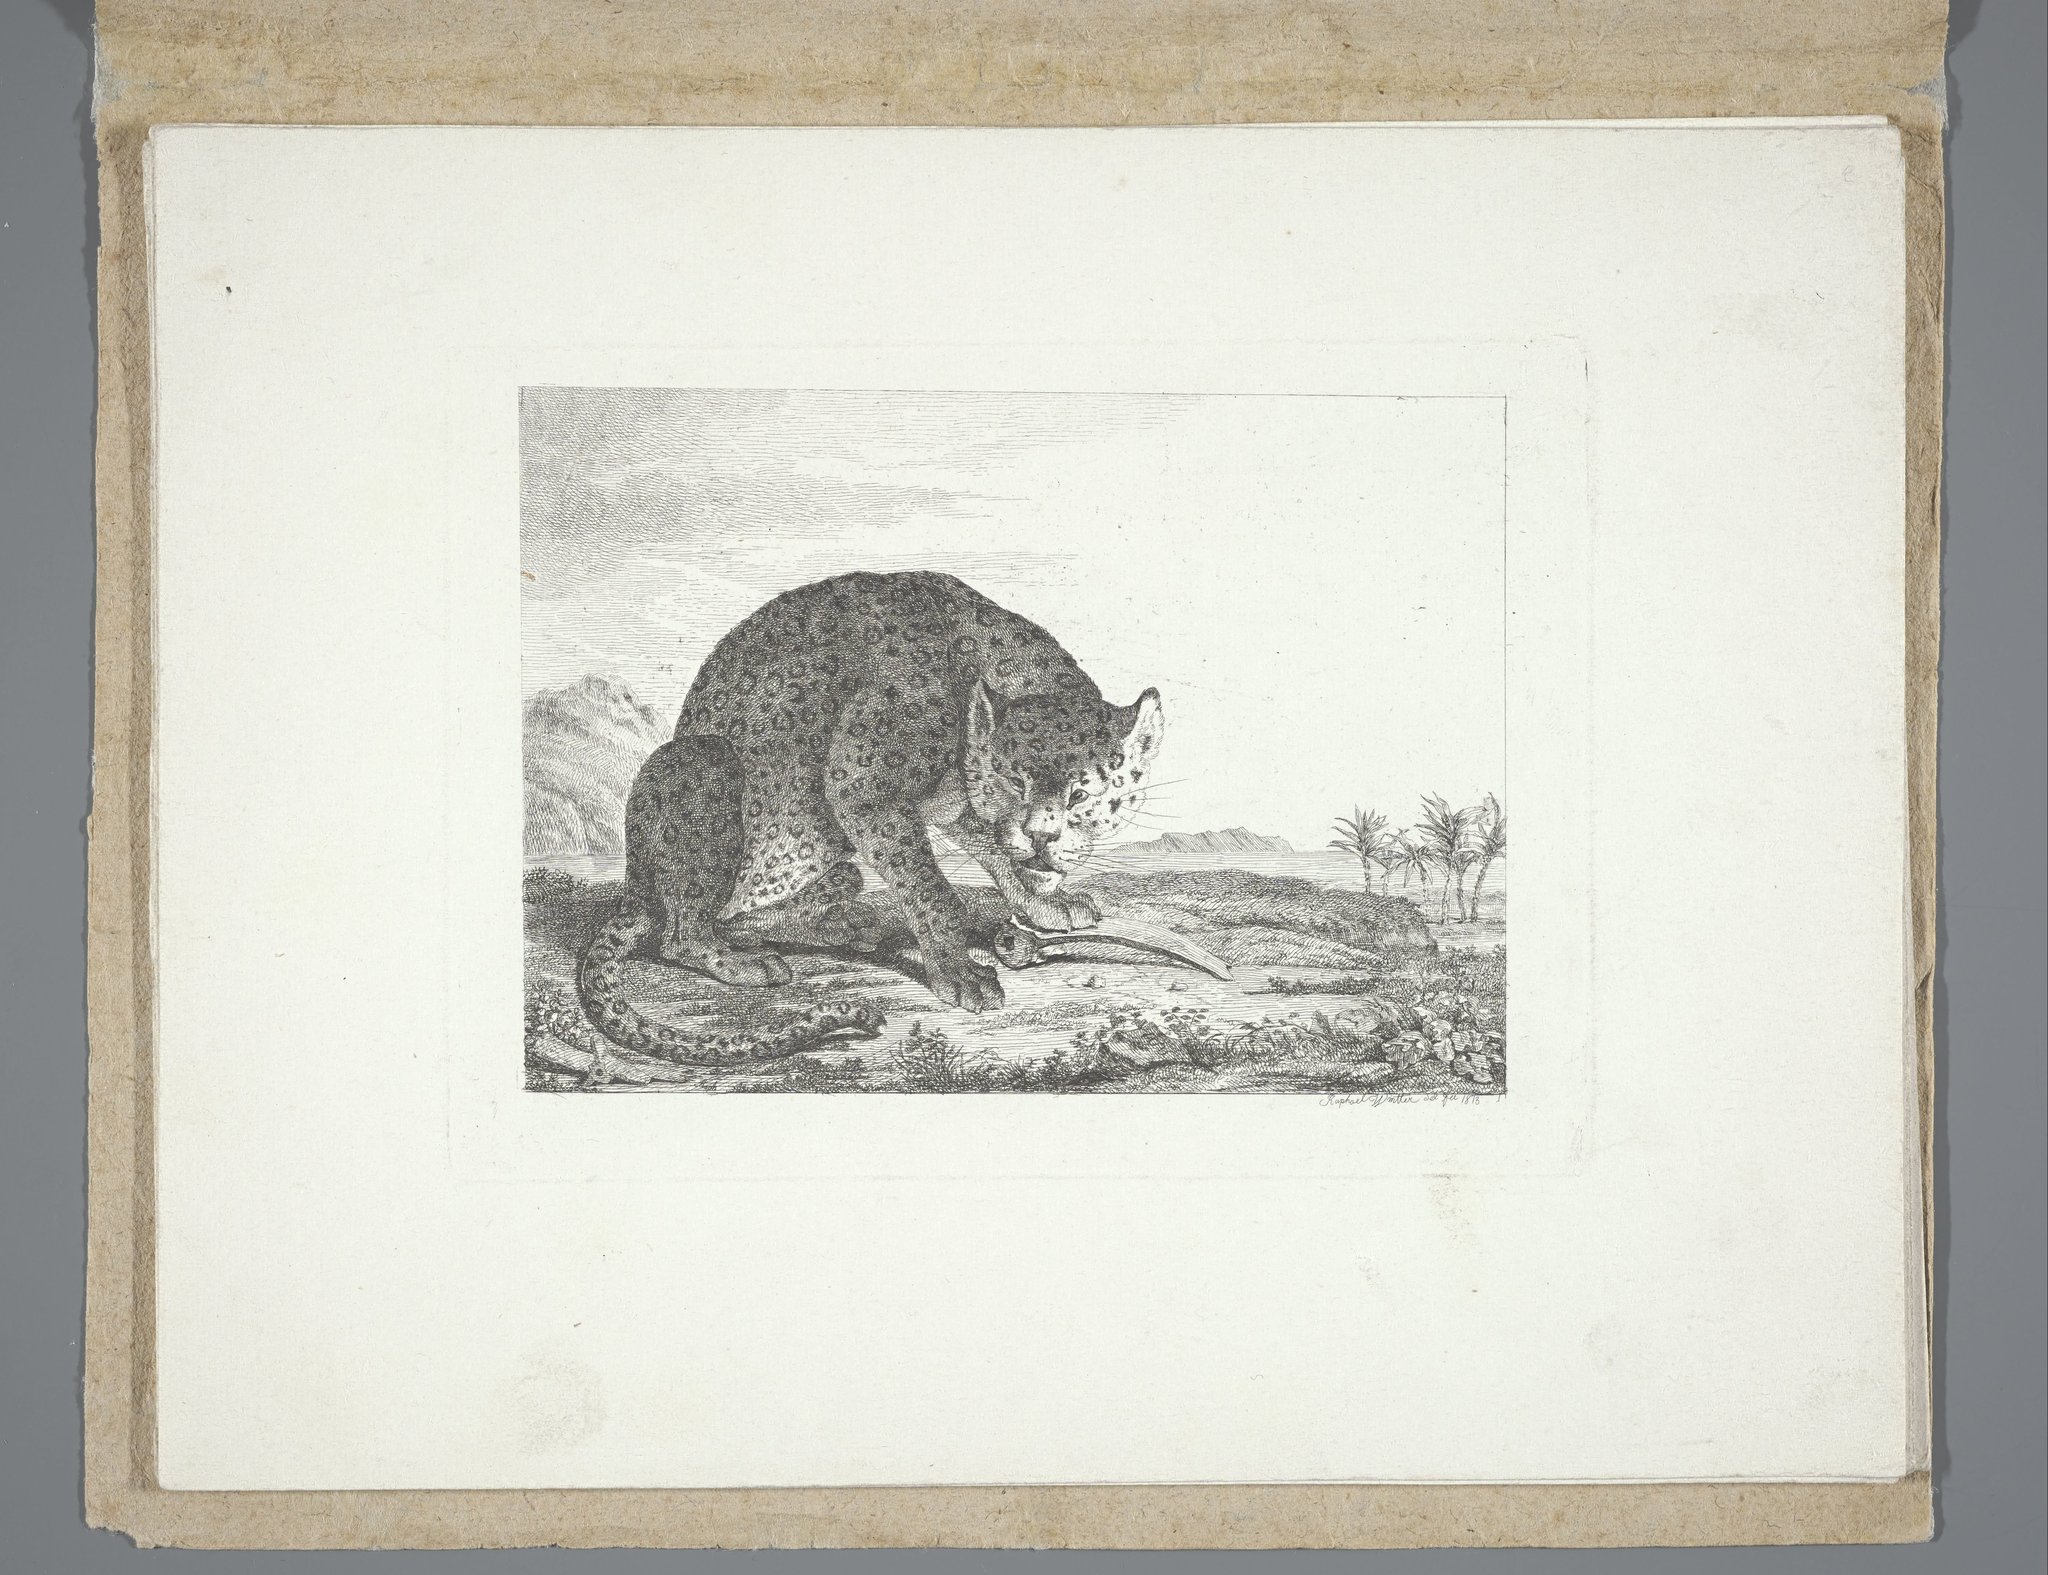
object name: print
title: Zwölf verschiedene Tieren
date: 1813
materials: paper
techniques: etching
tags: beasts of prey, predatory animals: leopard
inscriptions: date